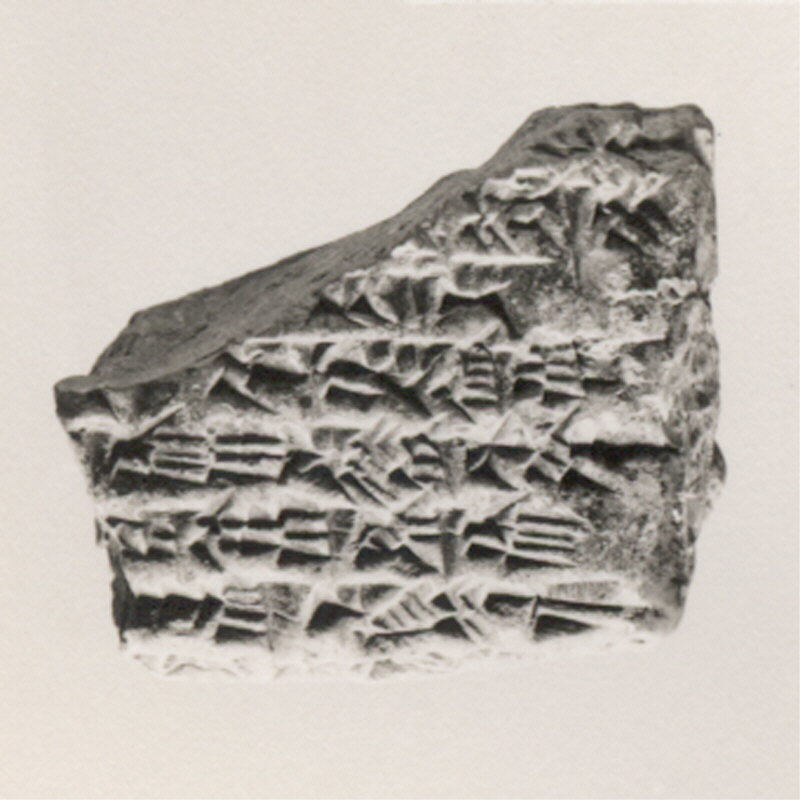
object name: cuneiform tablet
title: Cuneiform tablet: fragment of an imittu-promissory note for dates, Ebabbar archive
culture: babylonian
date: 626-539 BCE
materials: clay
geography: mesopotamia